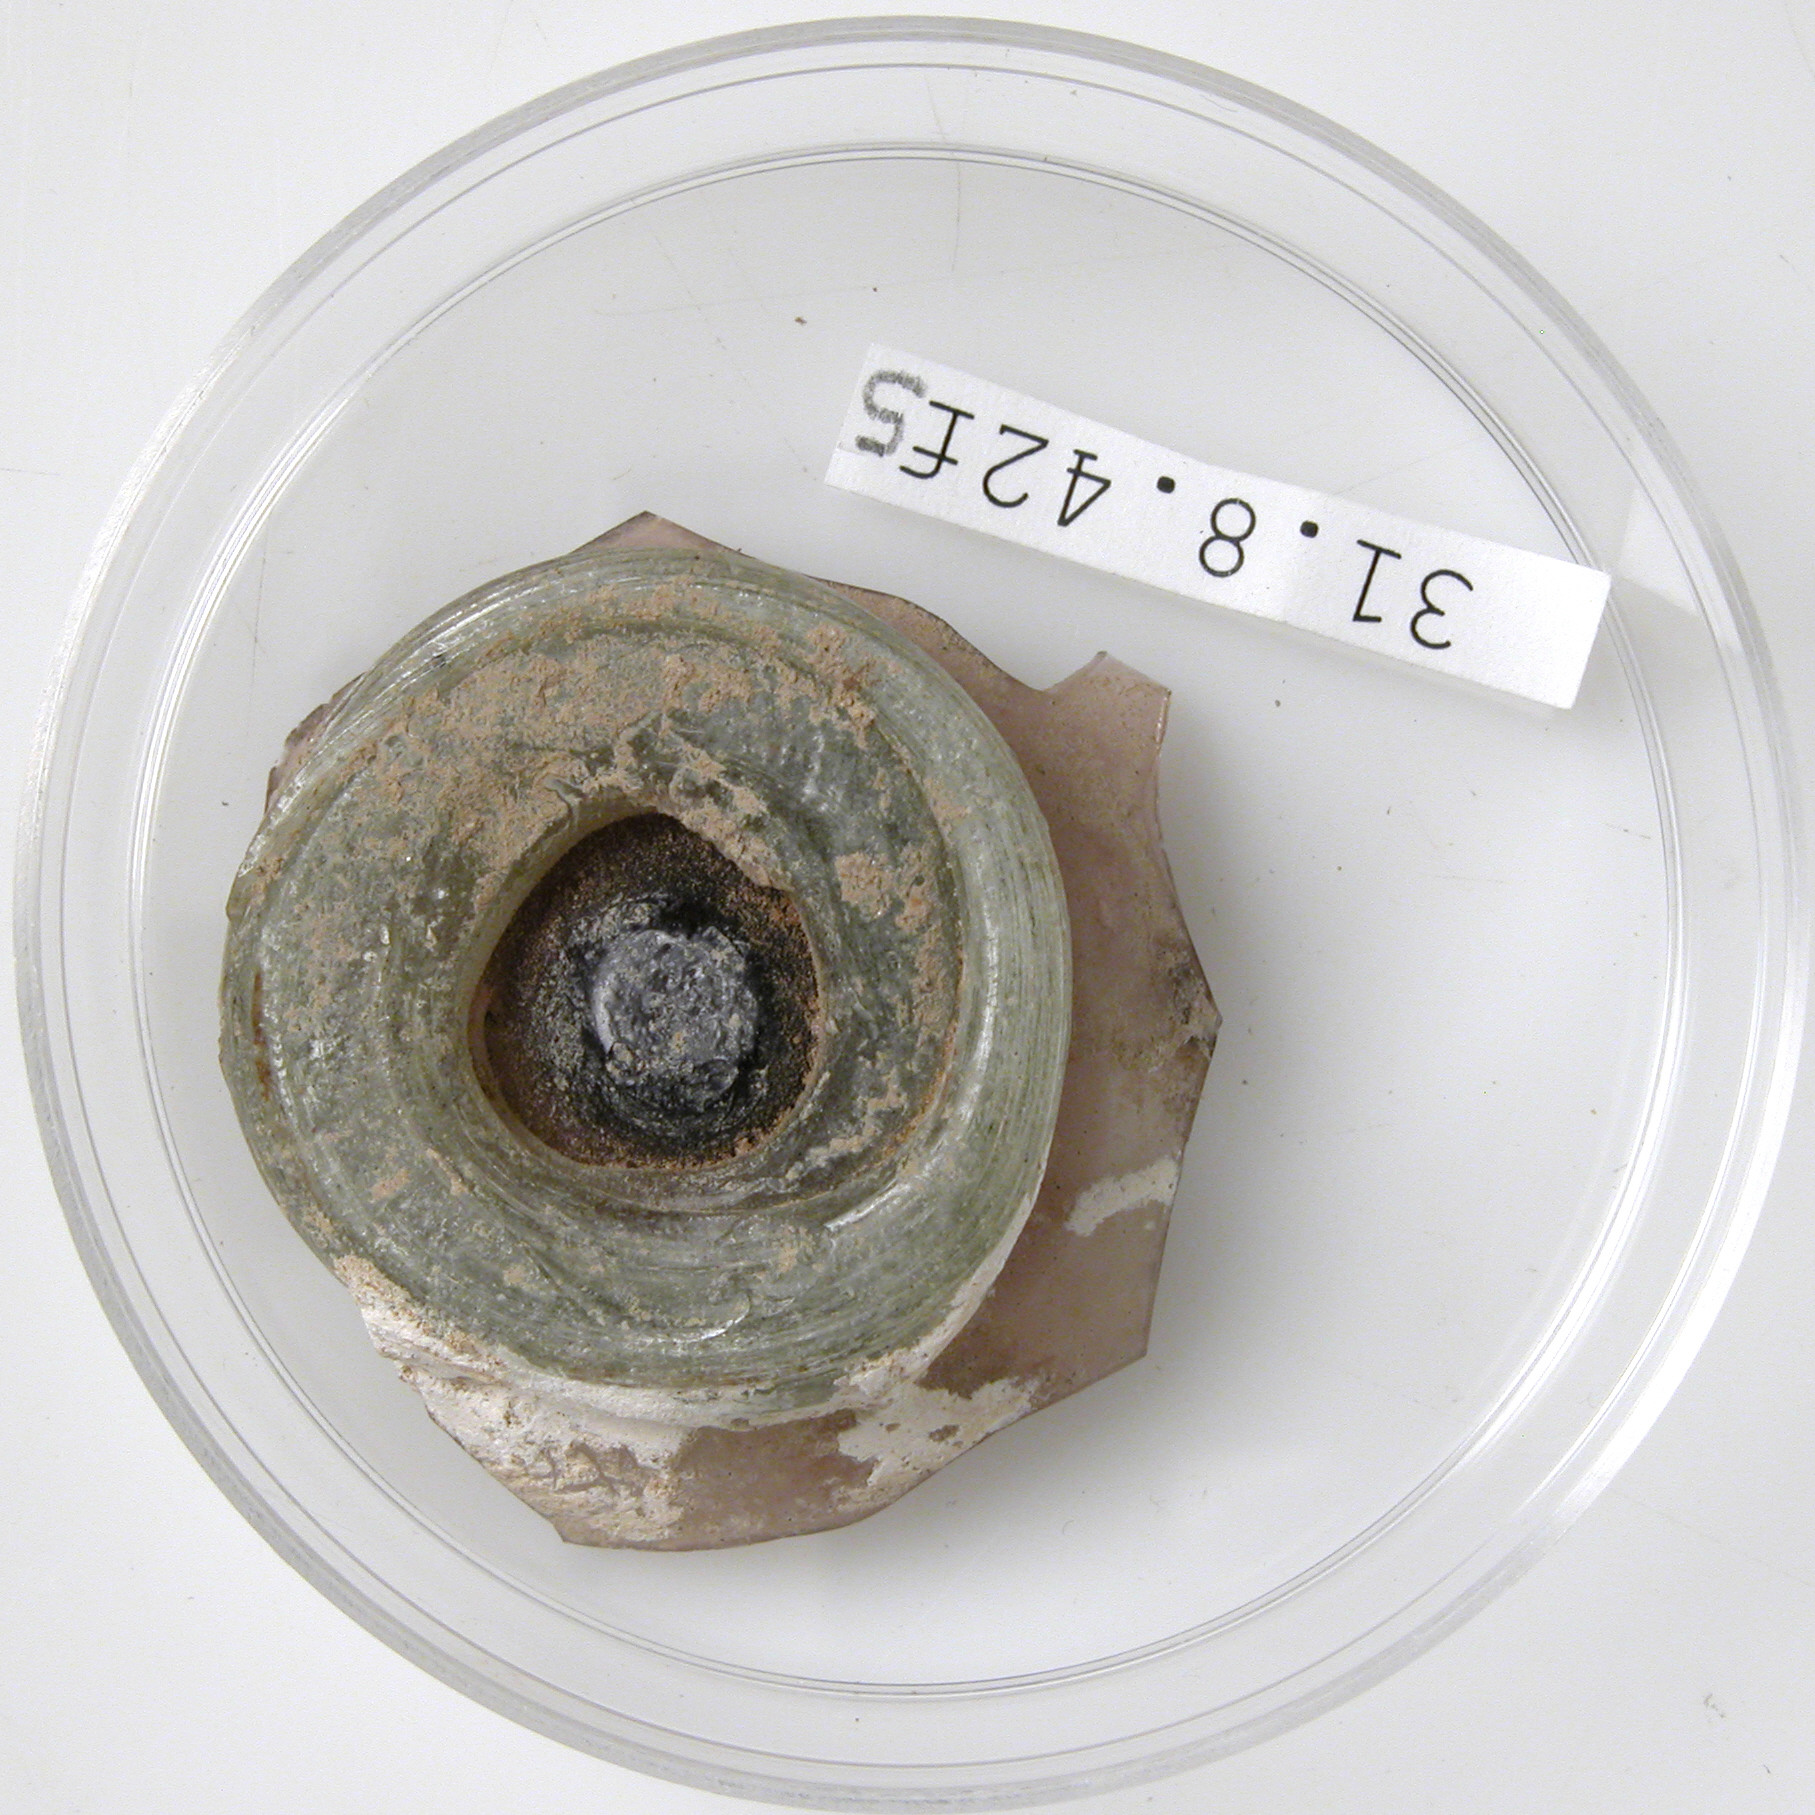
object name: fragment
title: Bottle Base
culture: coptic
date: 301-400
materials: glass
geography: egypt